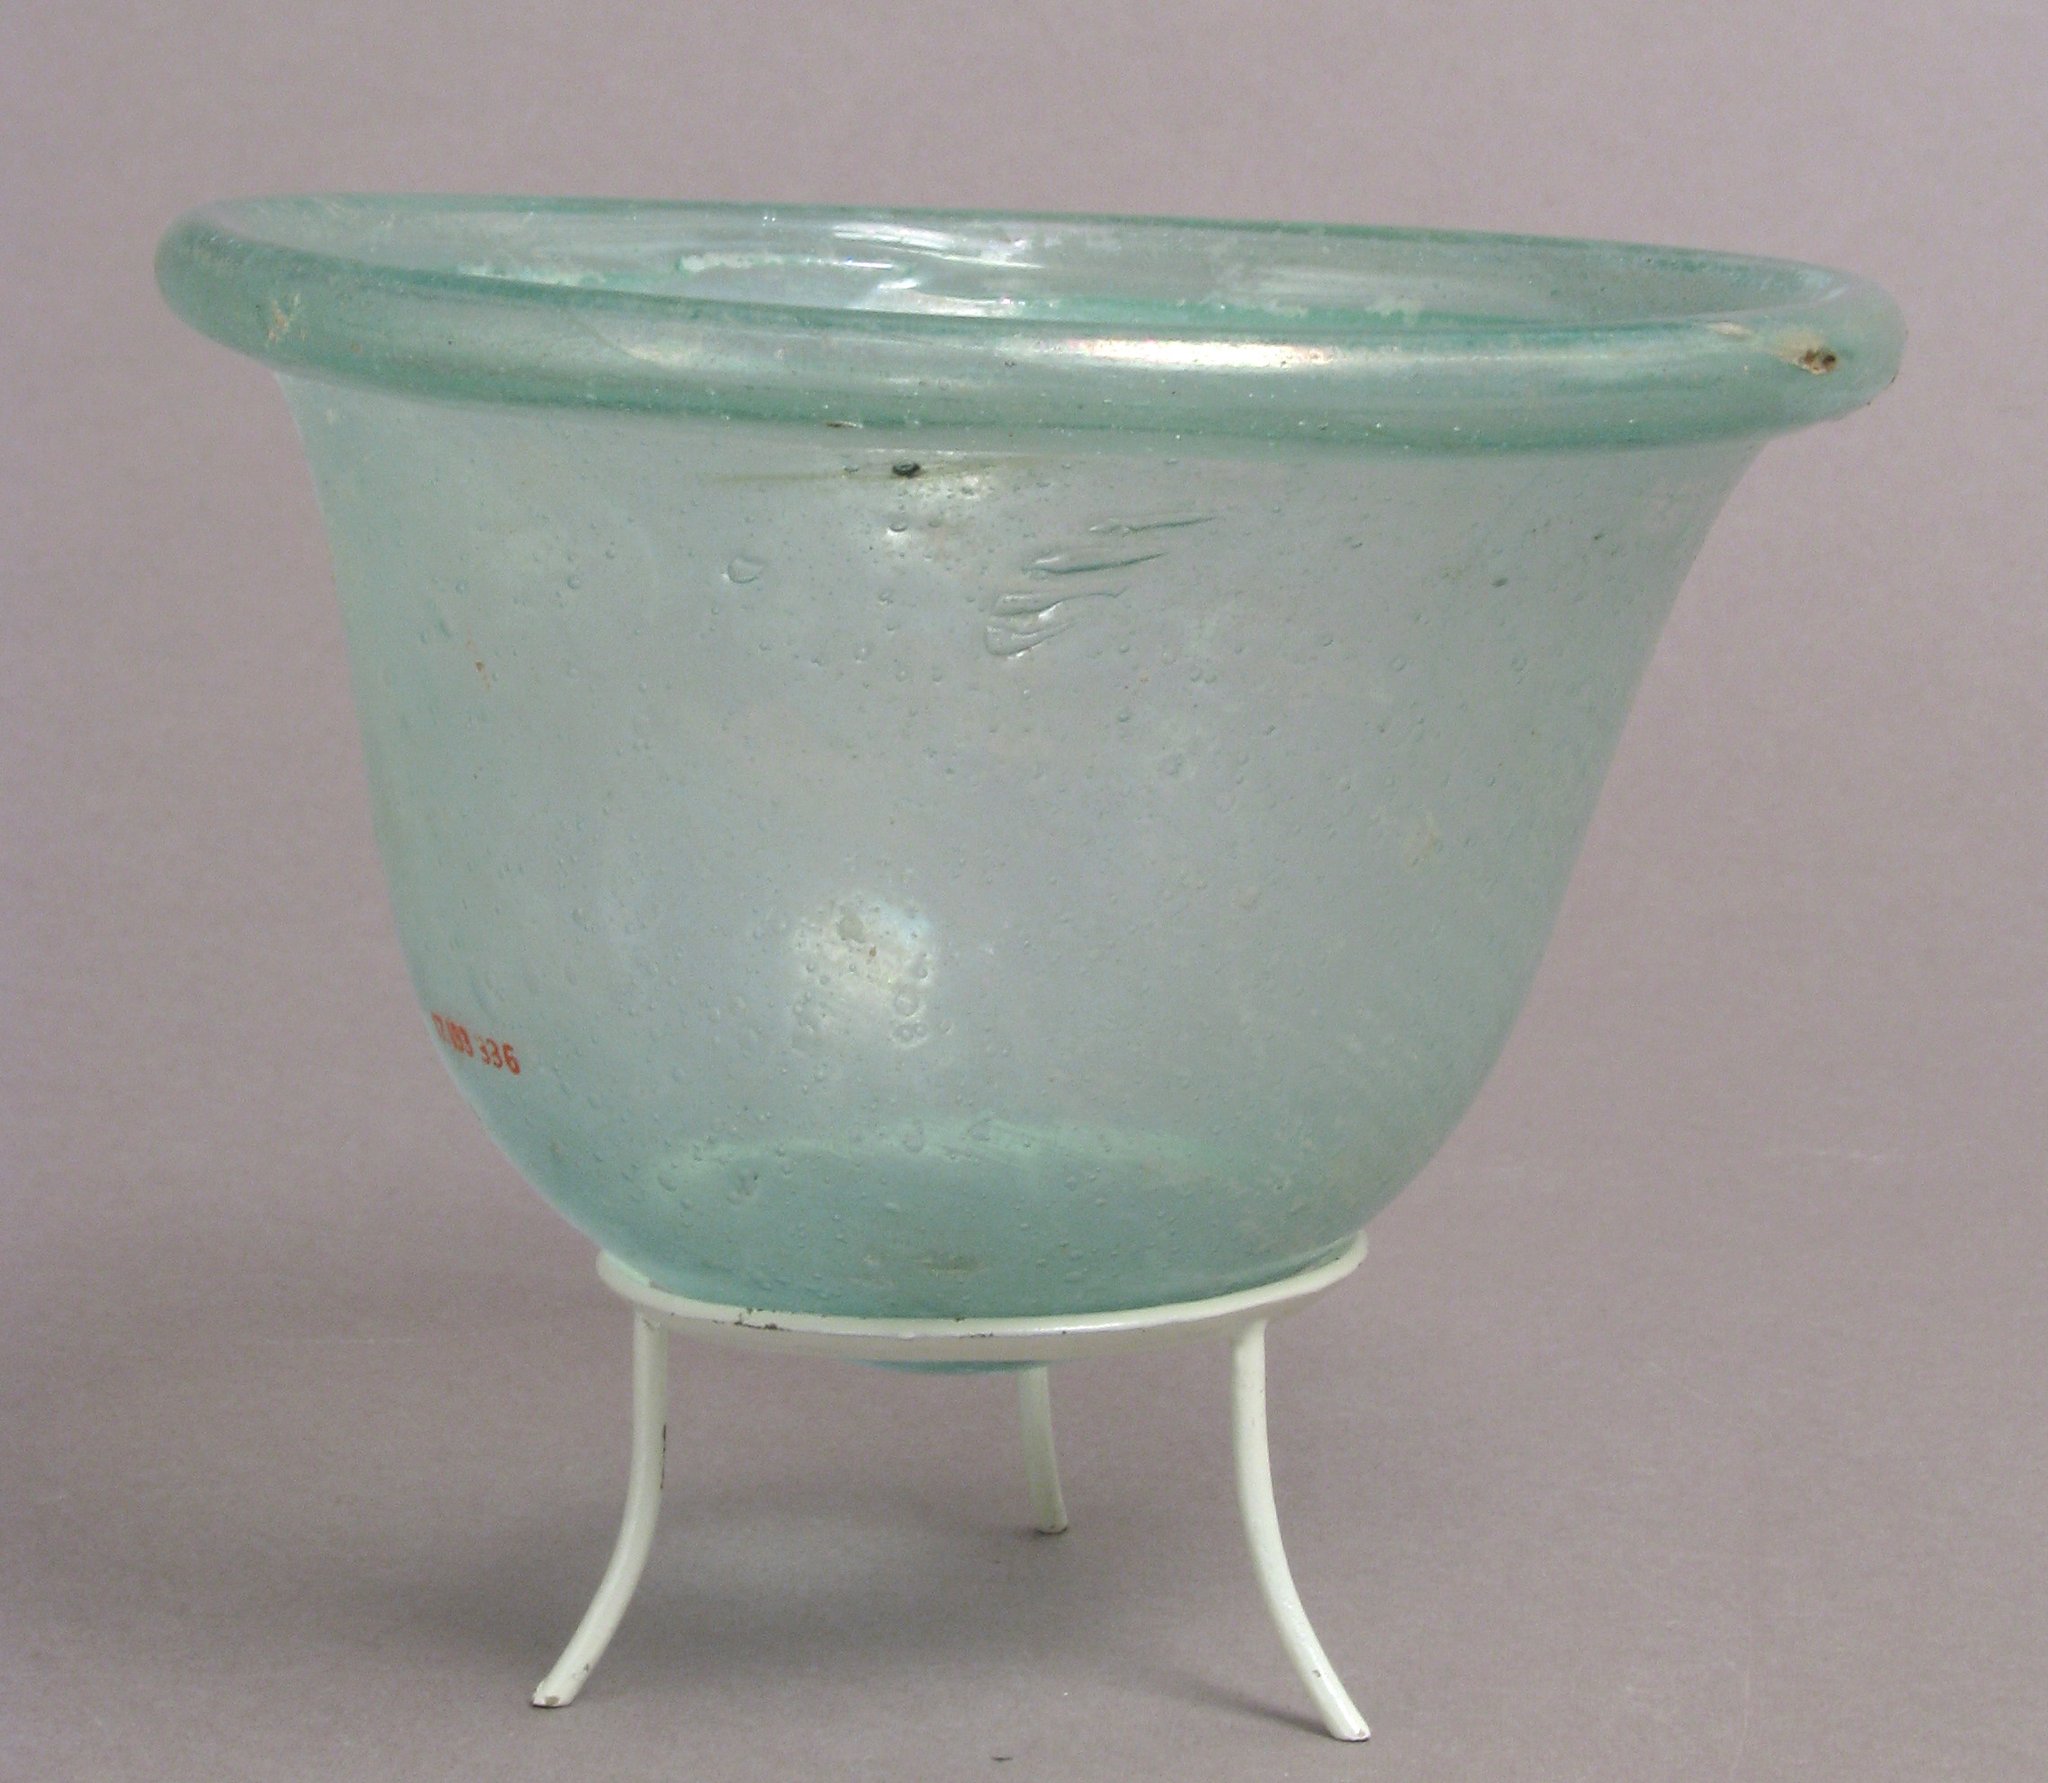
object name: cup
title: Palm Cup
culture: frankish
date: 601-800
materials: glass